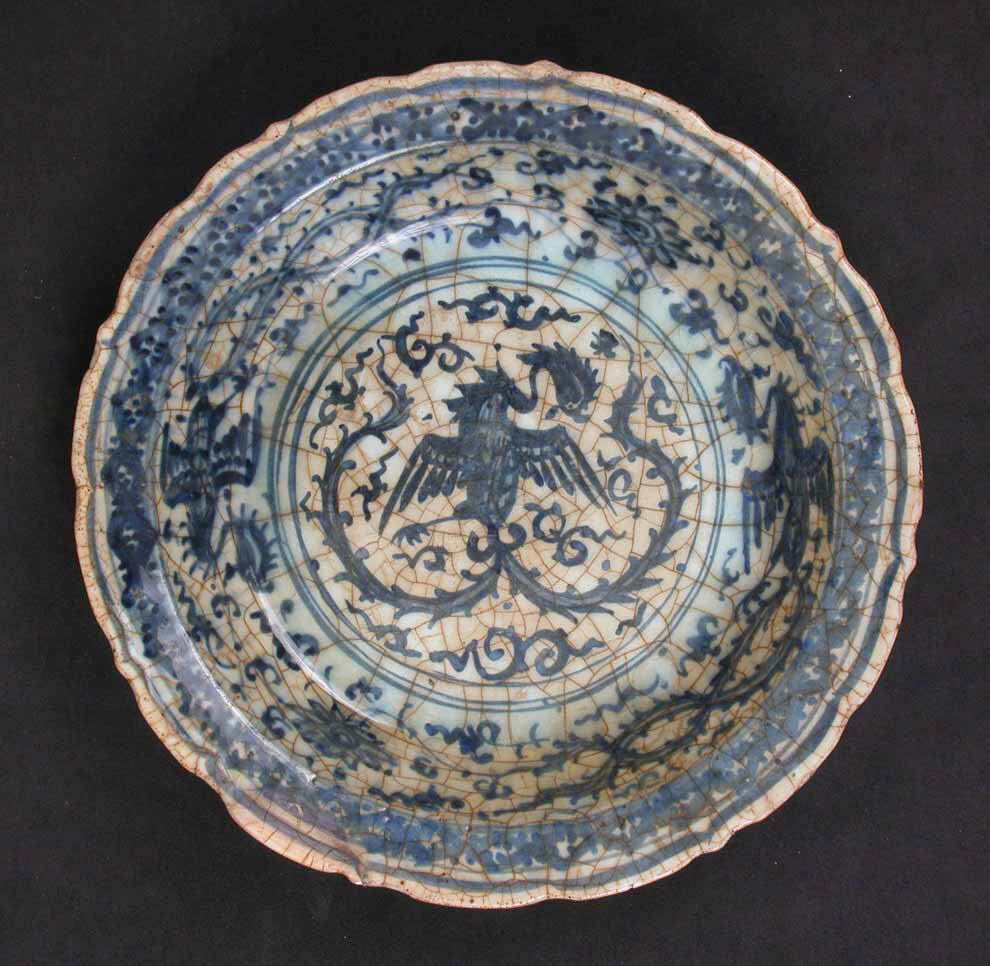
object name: dish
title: Dish with Phoenixes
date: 1667-1700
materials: earthenware, glaze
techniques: painting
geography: syria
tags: phoenix